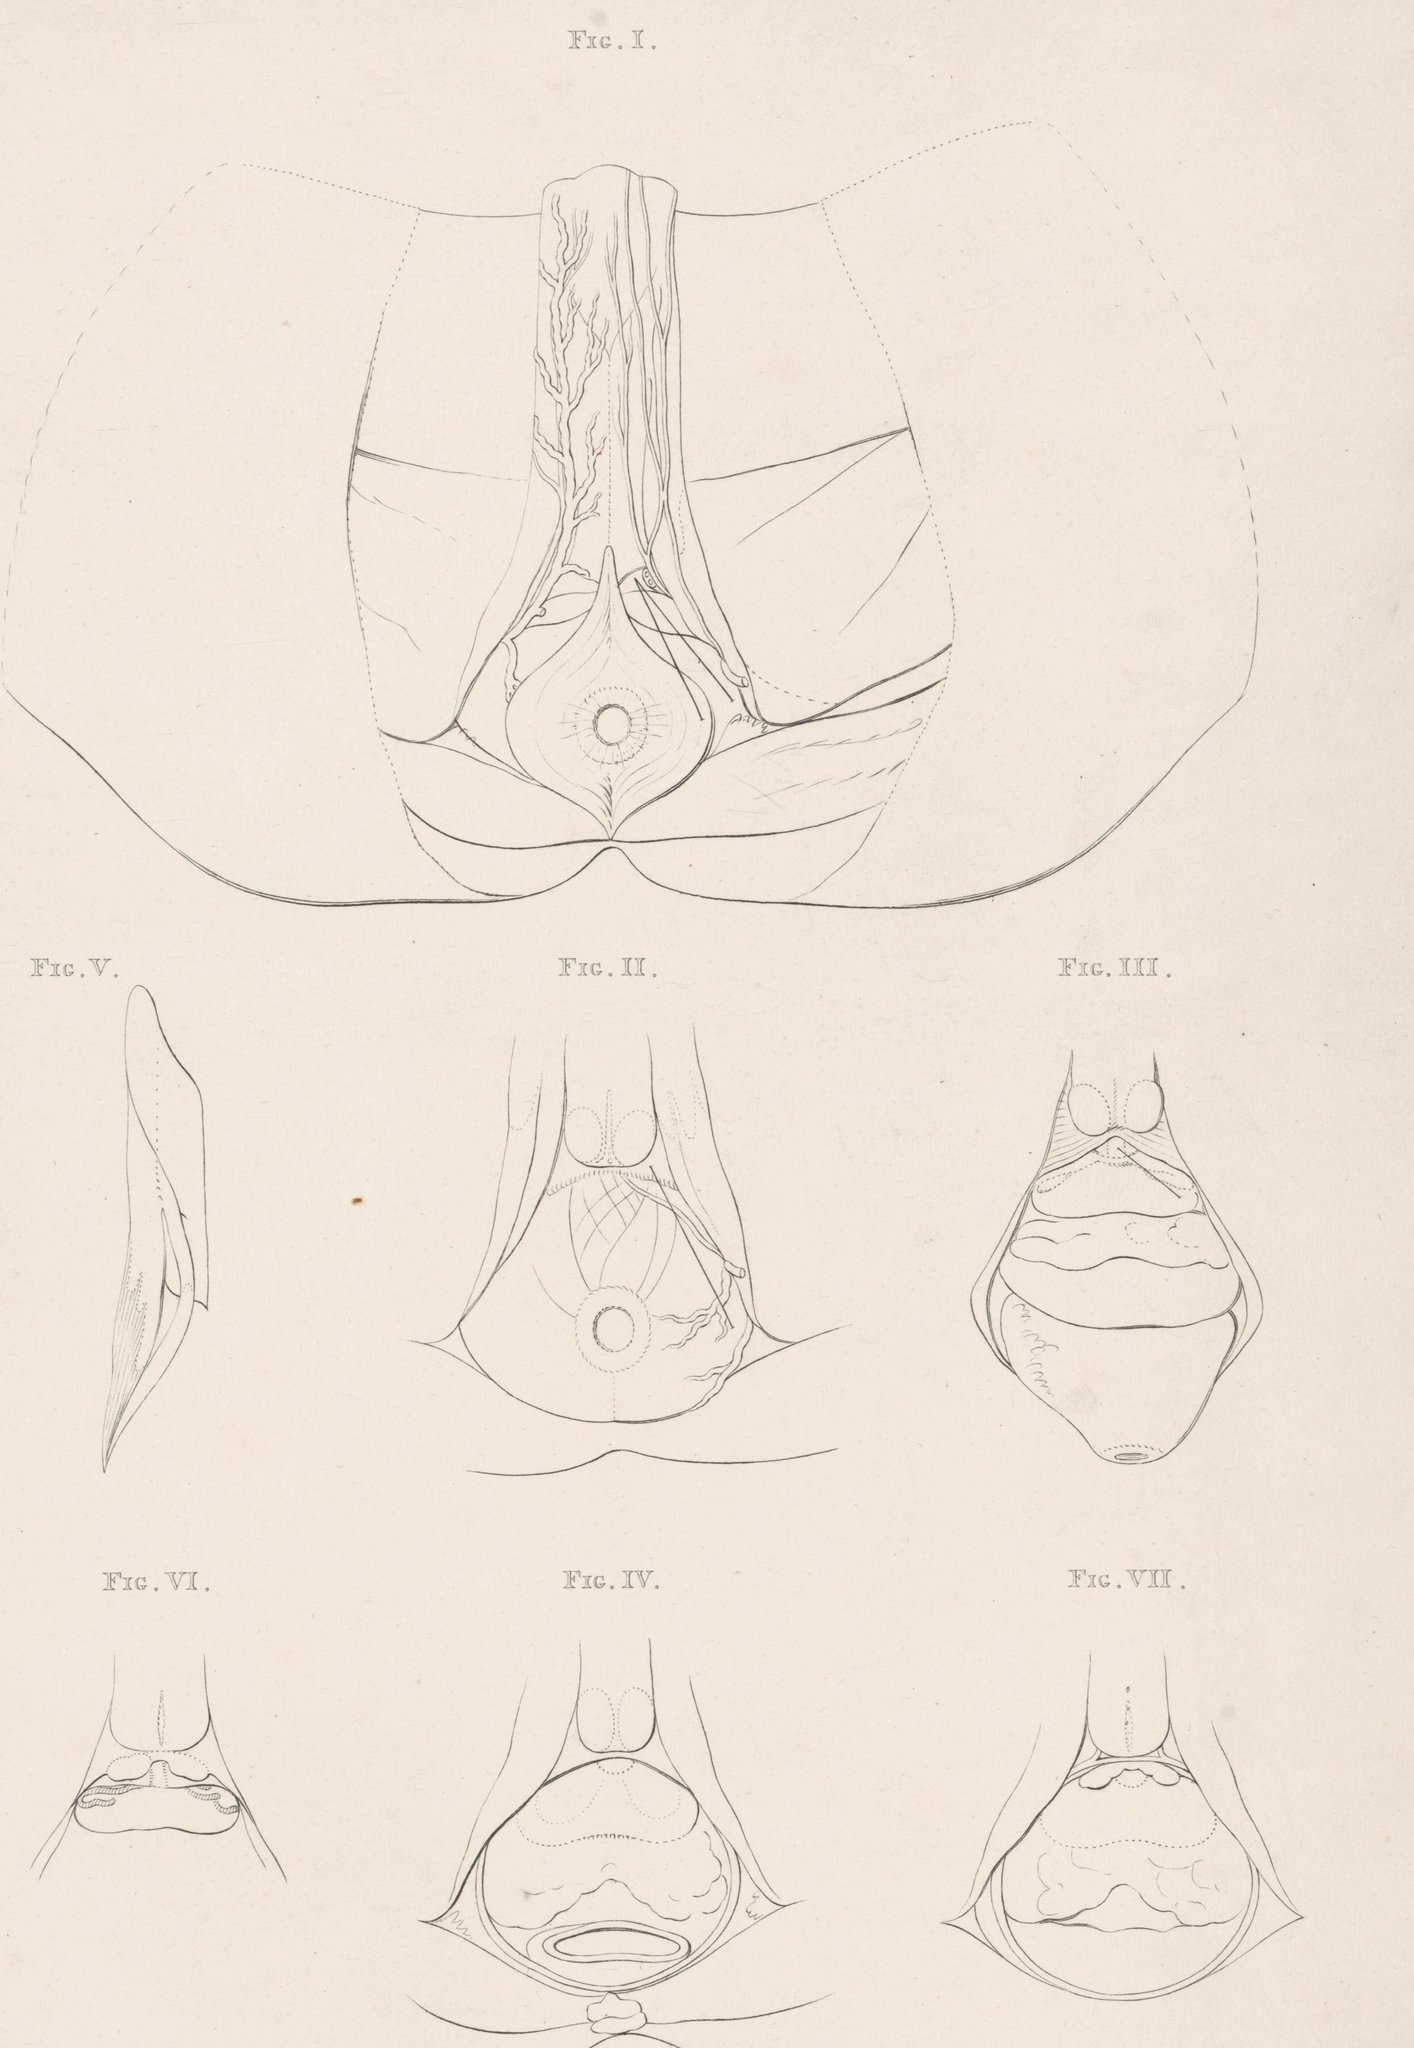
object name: print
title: Anatomische afbeelding van de pelvis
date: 1762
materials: paper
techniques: engraving, etching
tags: parts of the human body (skeleton excepted), pelvis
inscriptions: collector's mark: Lugt 2228